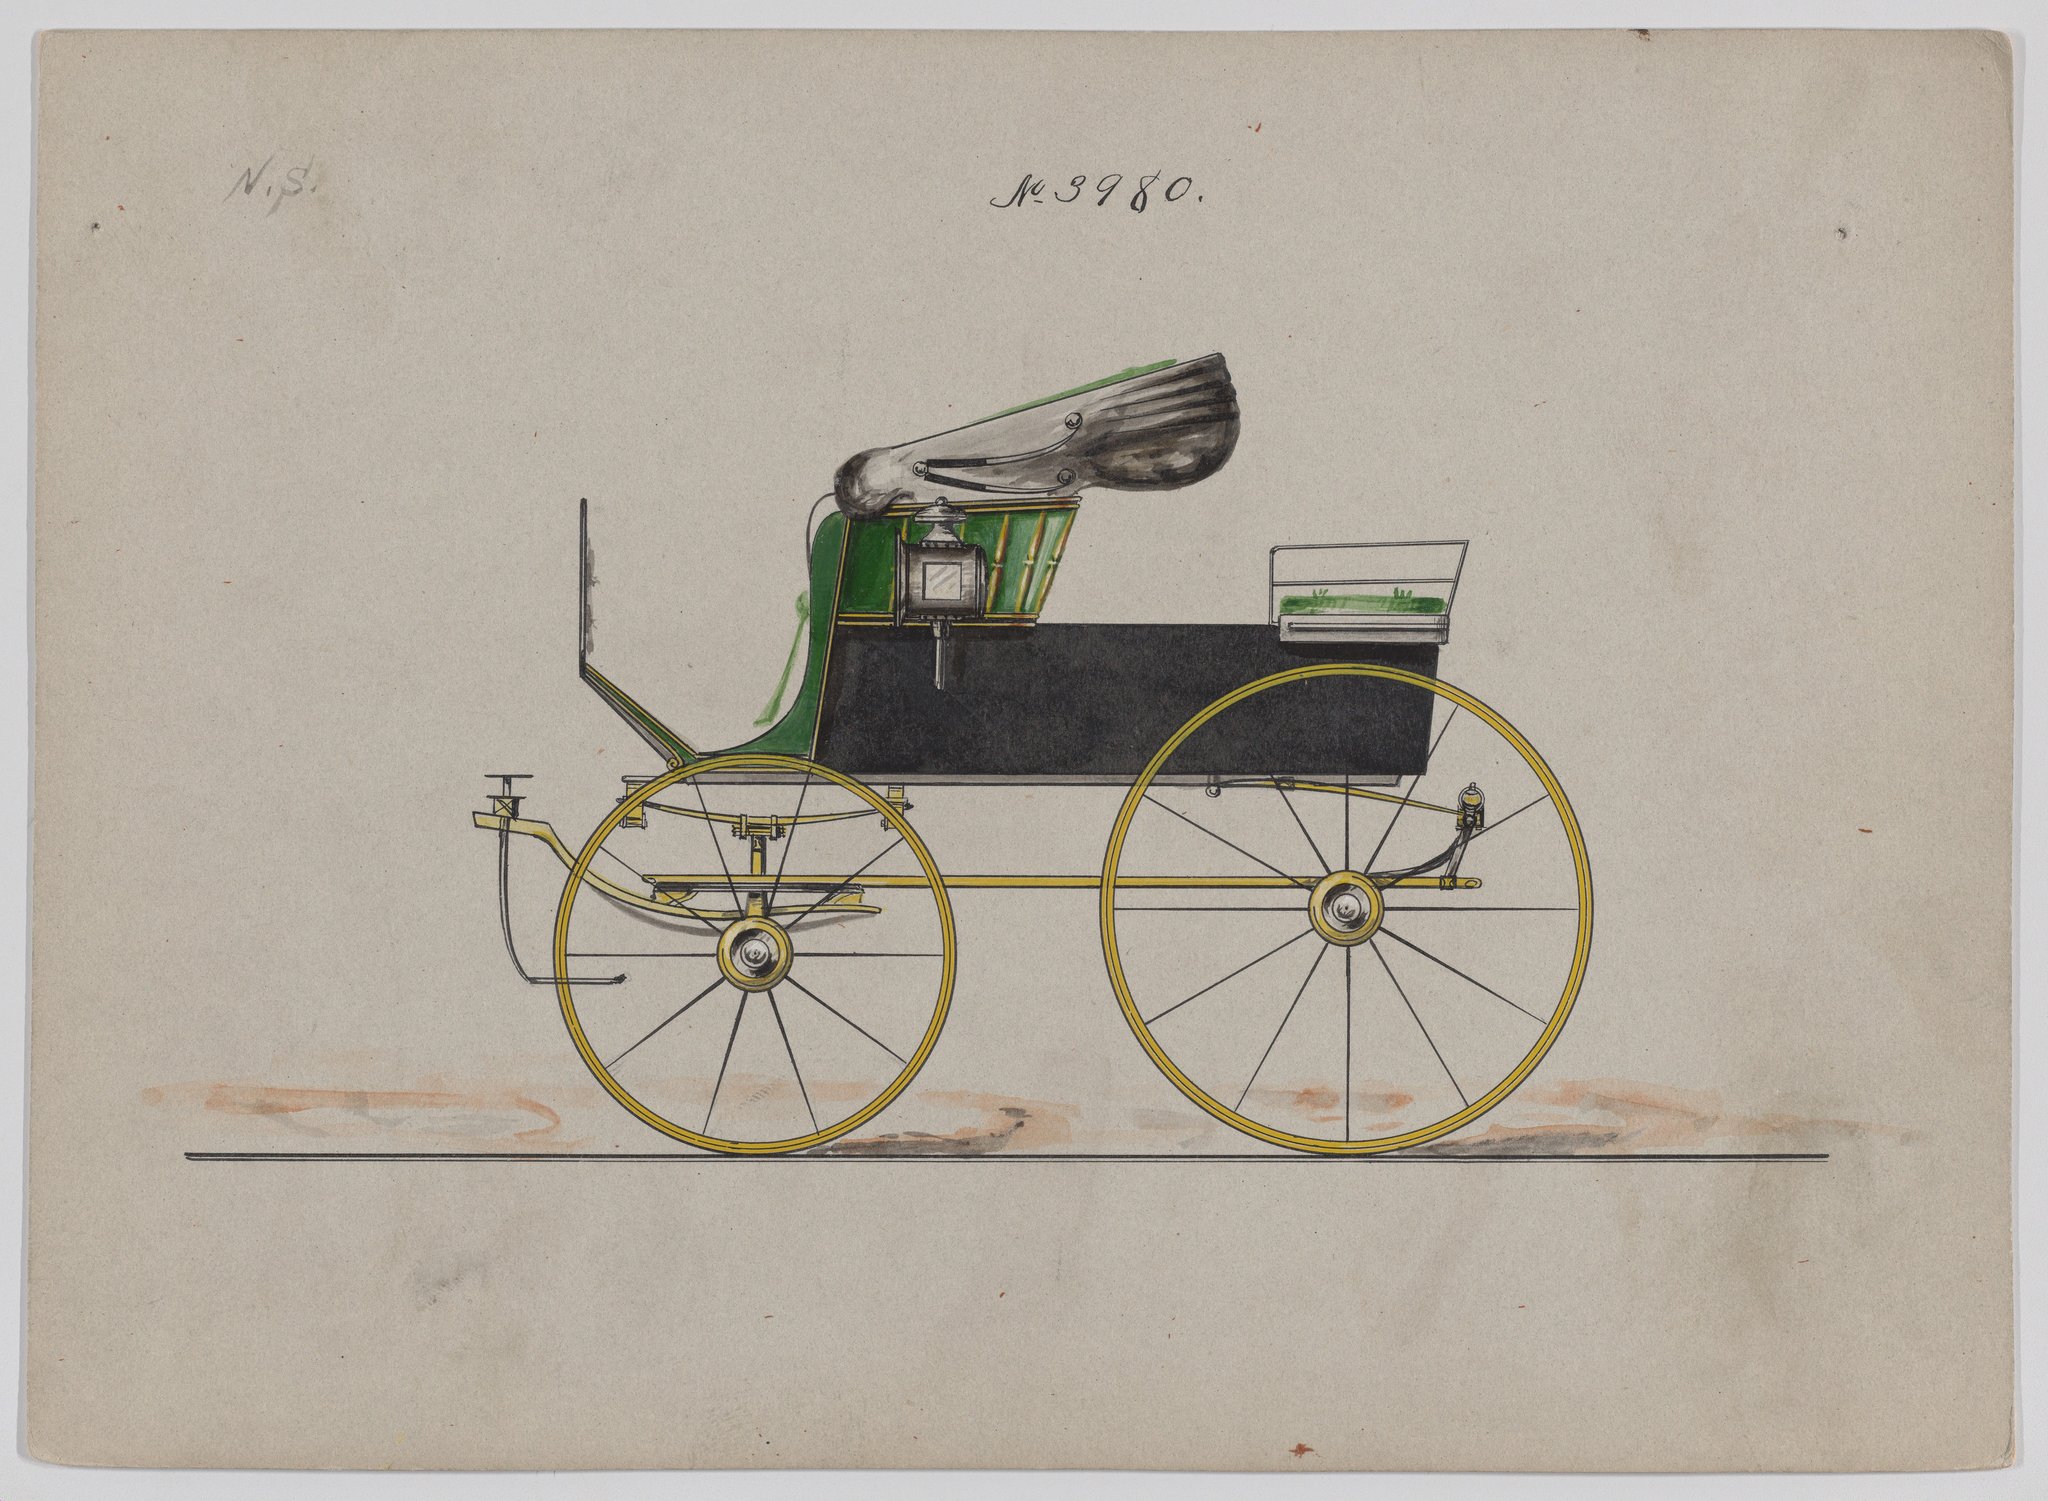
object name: drawing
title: Design for Demi Mail or Stanhope Phaeton, no. 3980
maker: brewster & co.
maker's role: manufacturer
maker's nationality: american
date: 1886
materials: gouache, gum arabic, ink, watercolor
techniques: pen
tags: carriages